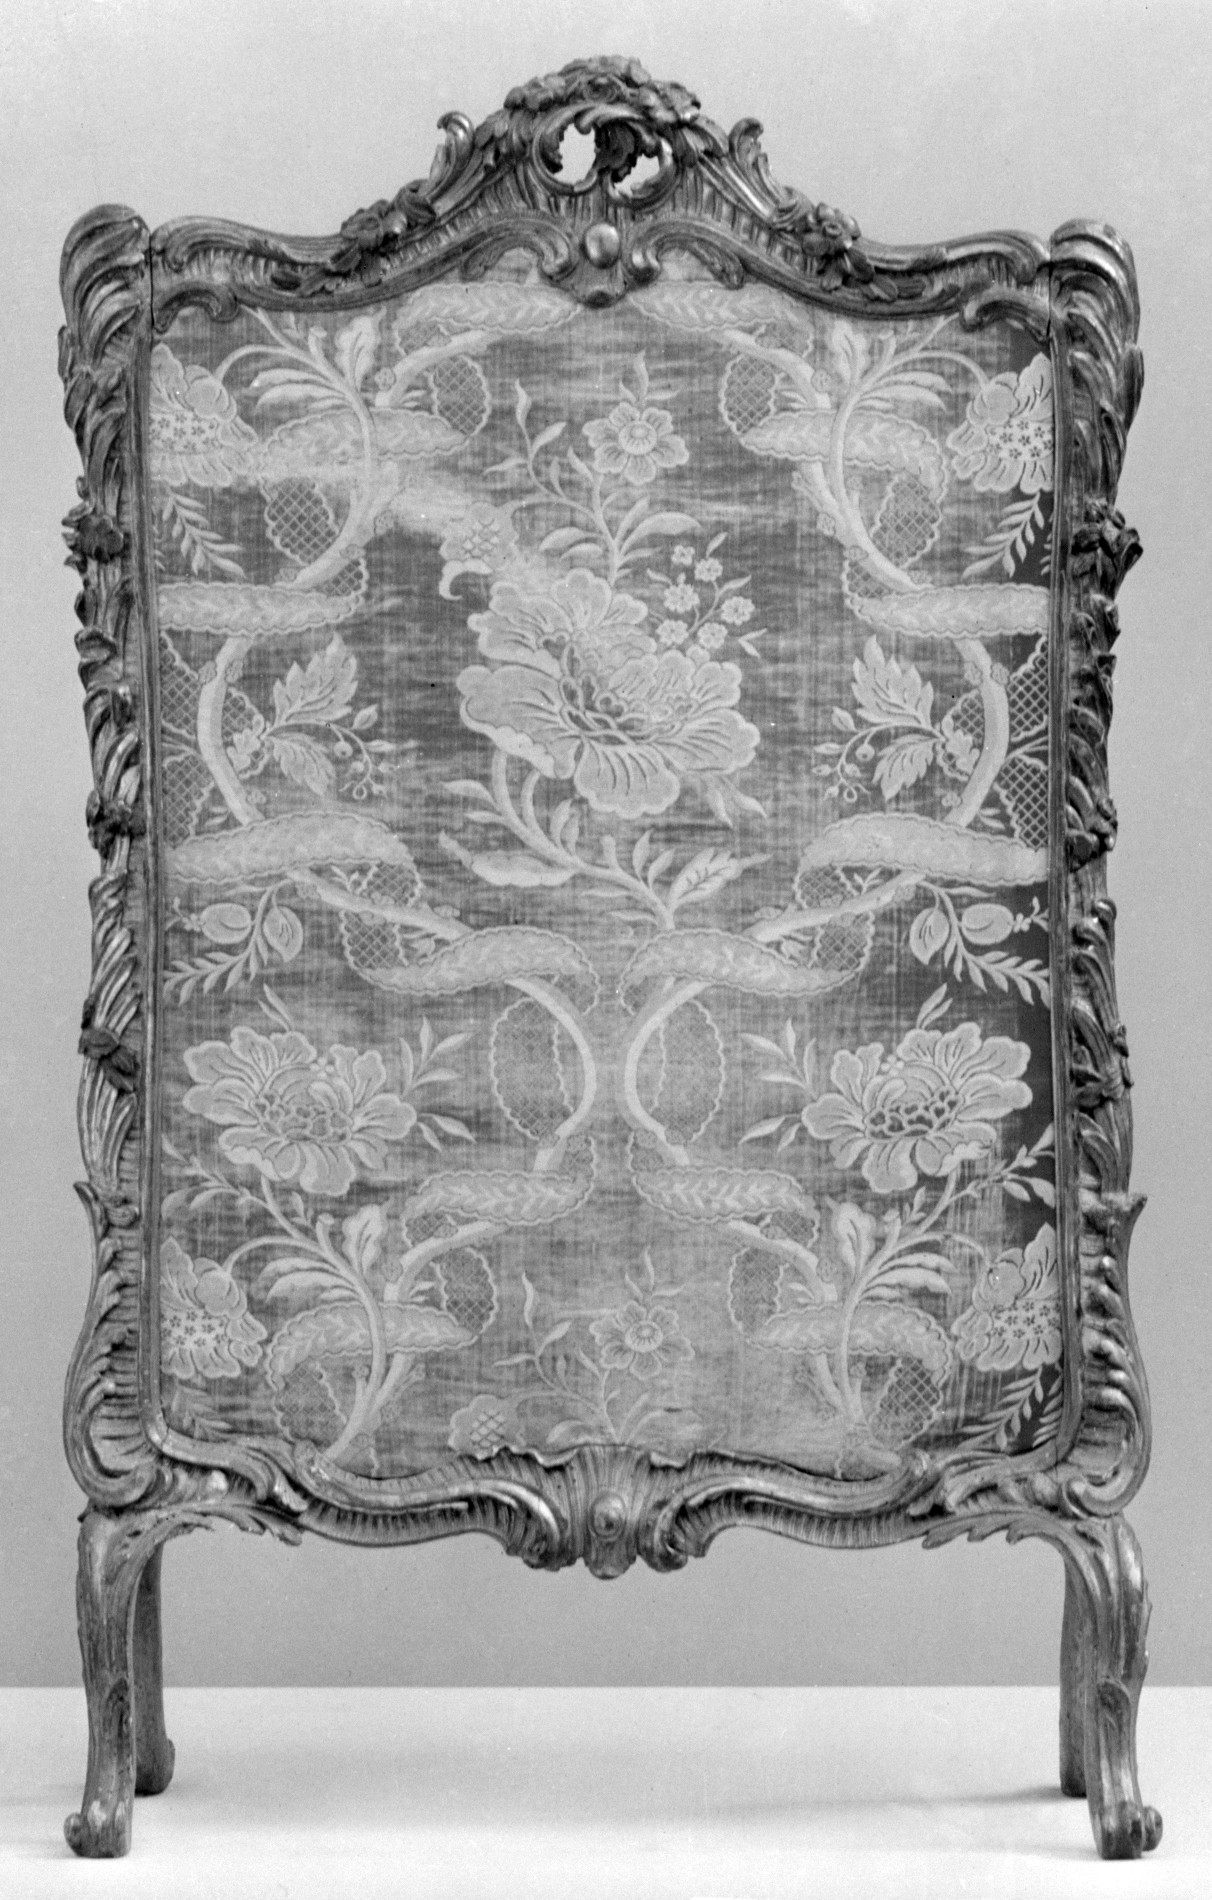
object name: fire screen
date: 1701-1800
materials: wood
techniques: gilding, painting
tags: flowers